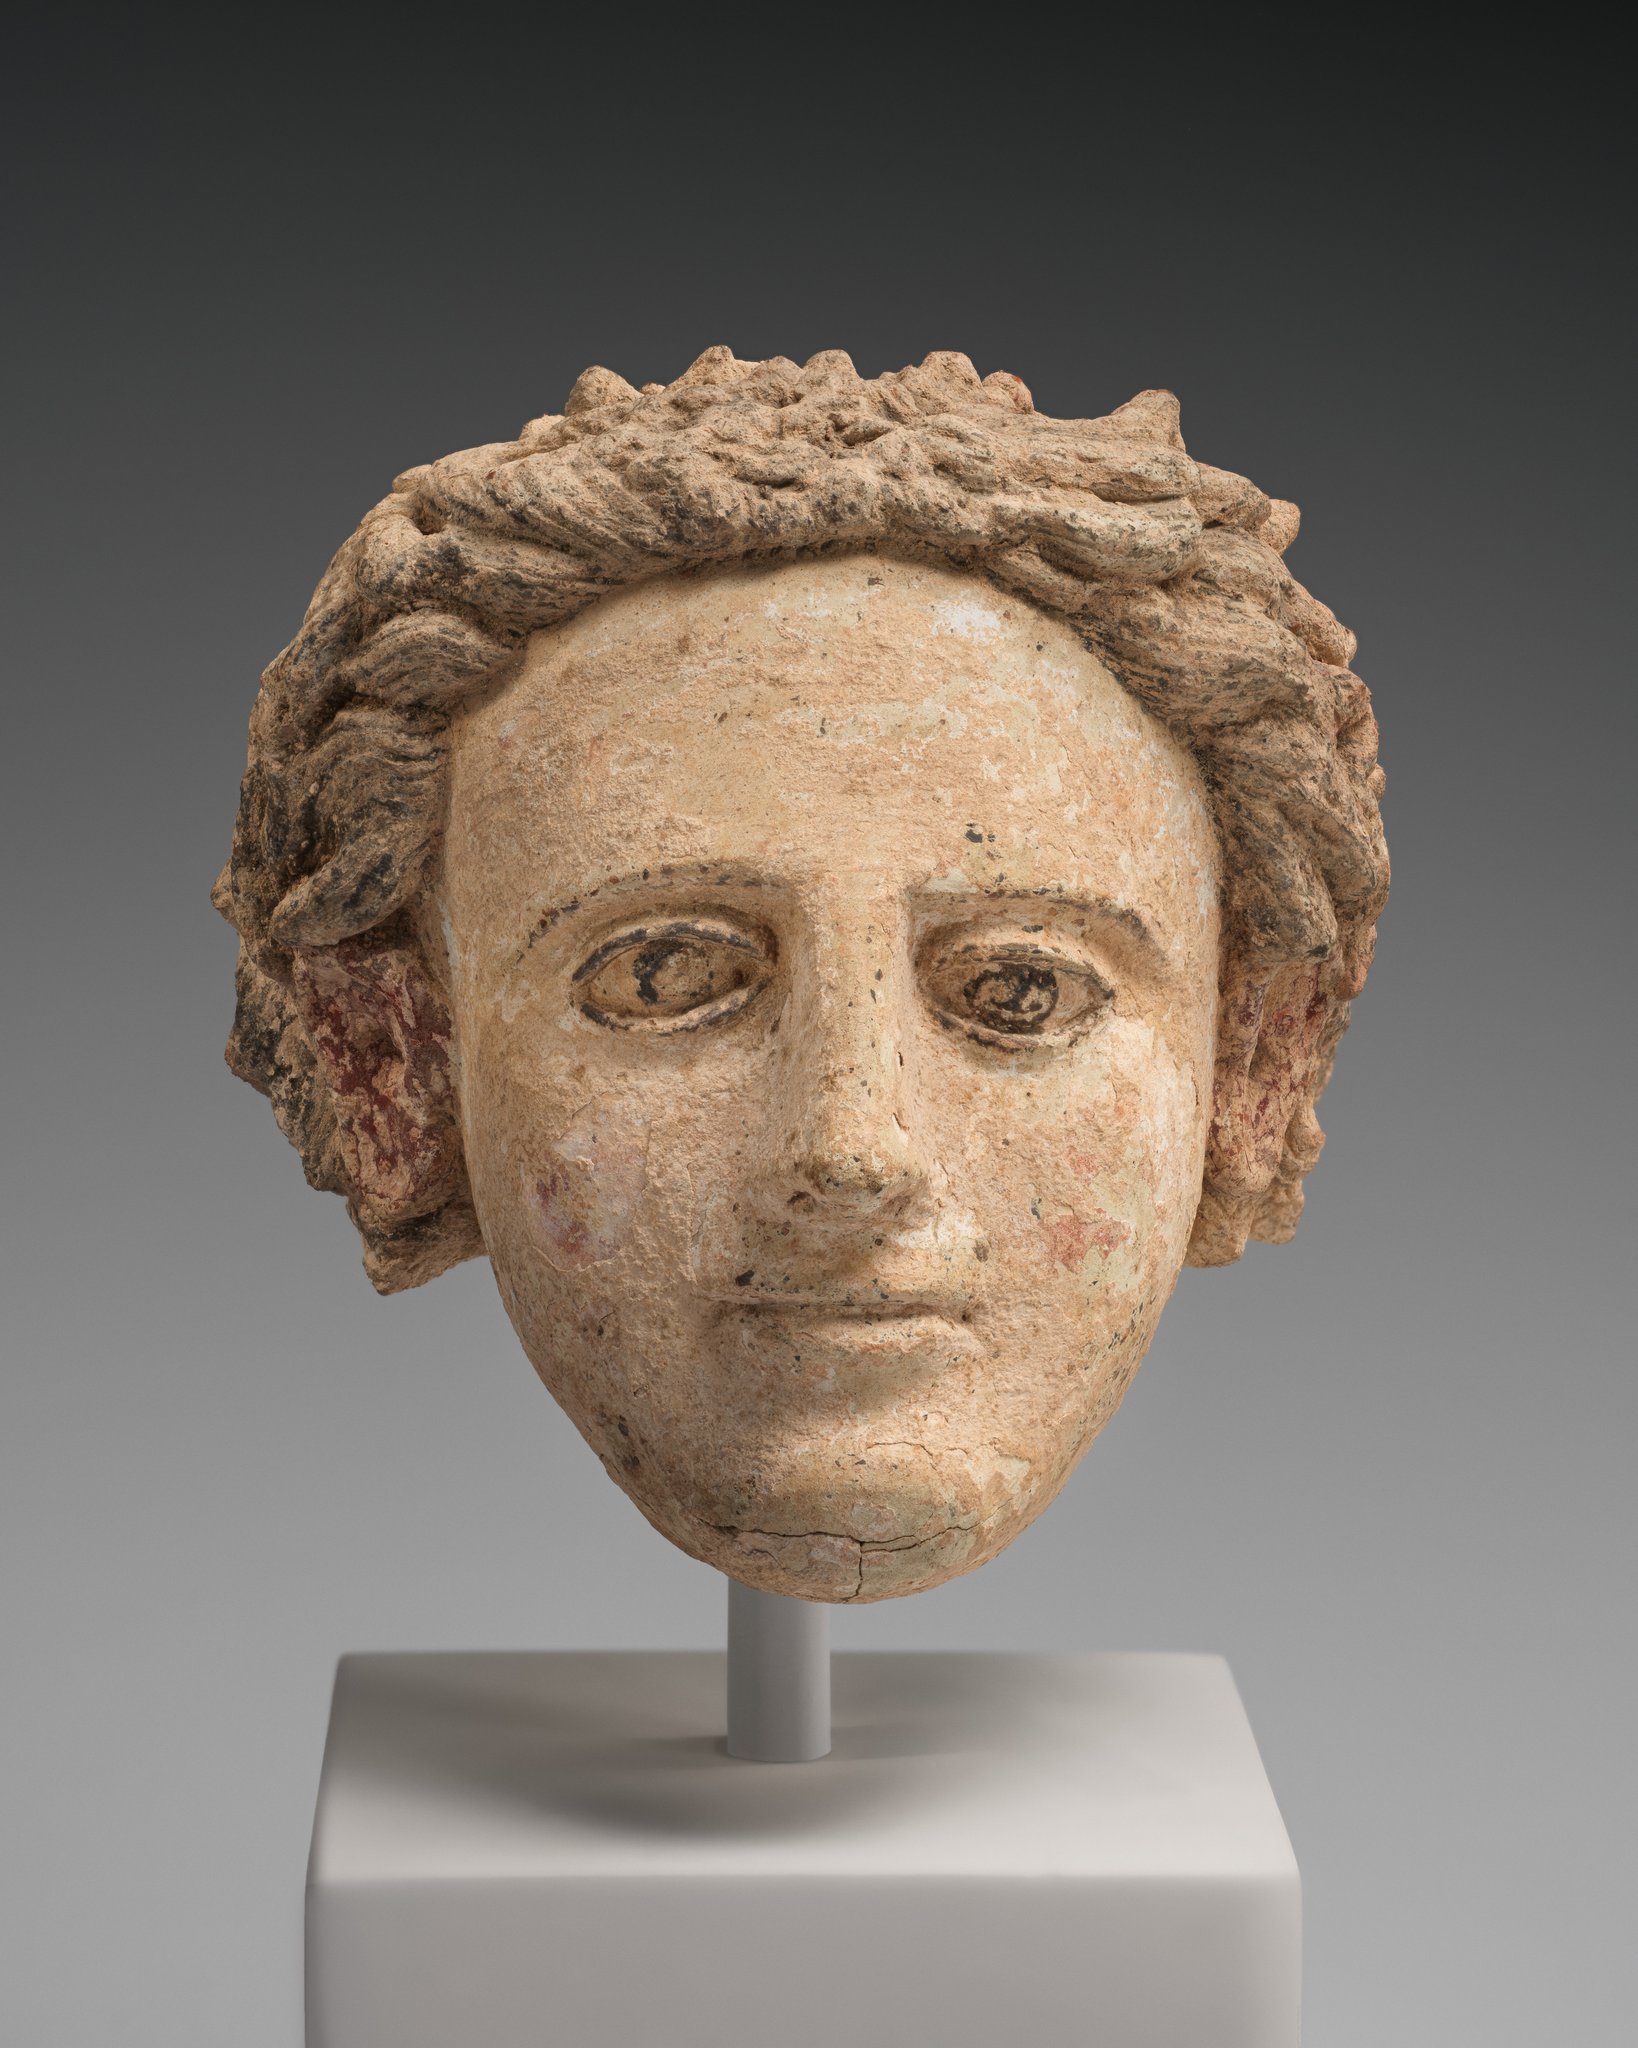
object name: head of a youth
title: Terracotta head of a youth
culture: cypriot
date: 200-101 BCE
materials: terracotta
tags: heads,men